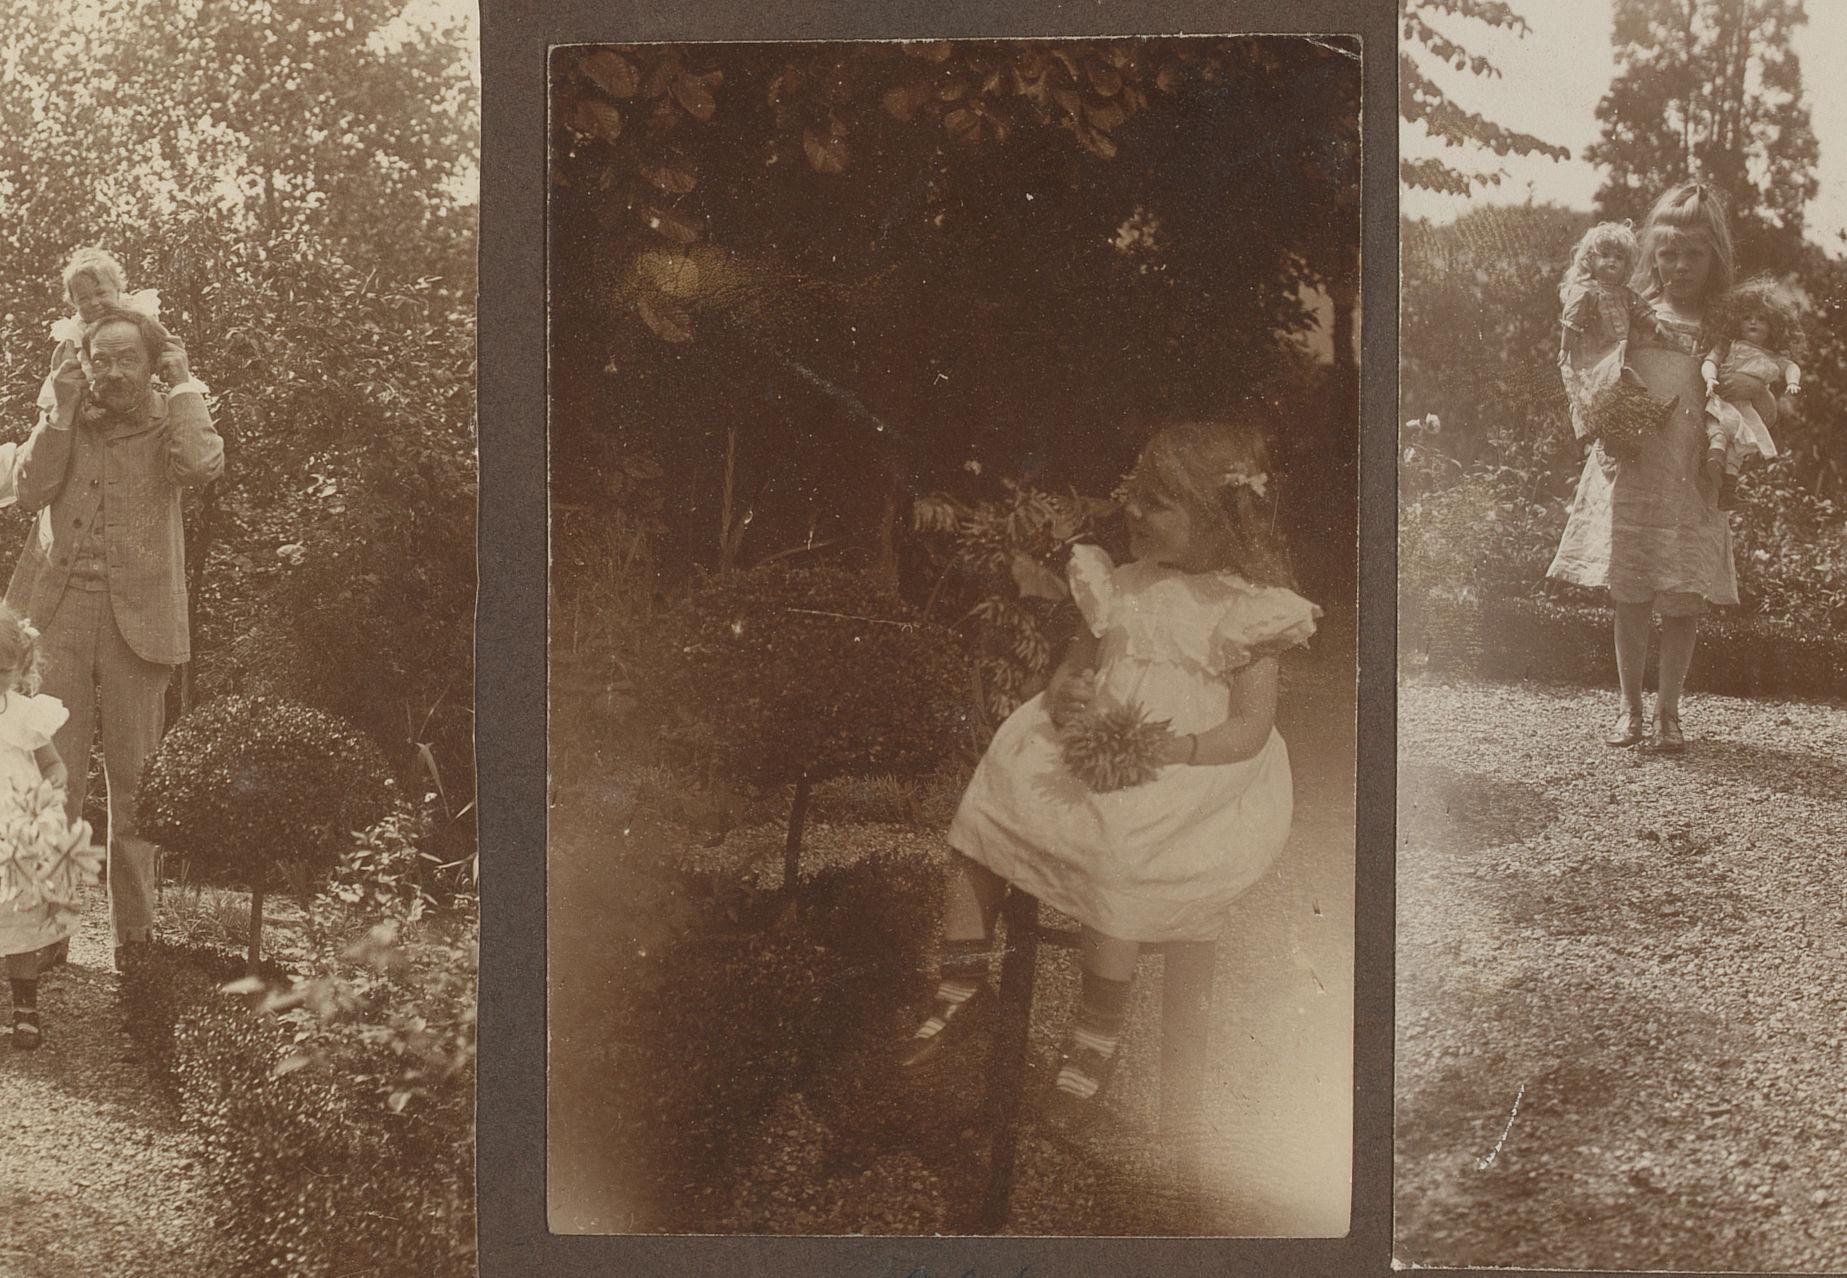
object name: photograph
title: Joanna Diepenbrock zittend op een kruk in de tuin van villa de Hoeve met een bloem in de hand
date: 1906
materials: paper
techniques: gelatin silver print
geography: laren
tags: amsterdam, cut flowers; nosegay, bunch of flowers, historical persons - bb - woman, stool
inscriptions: inscription: ‘190[...]/ "de Hoeve"’